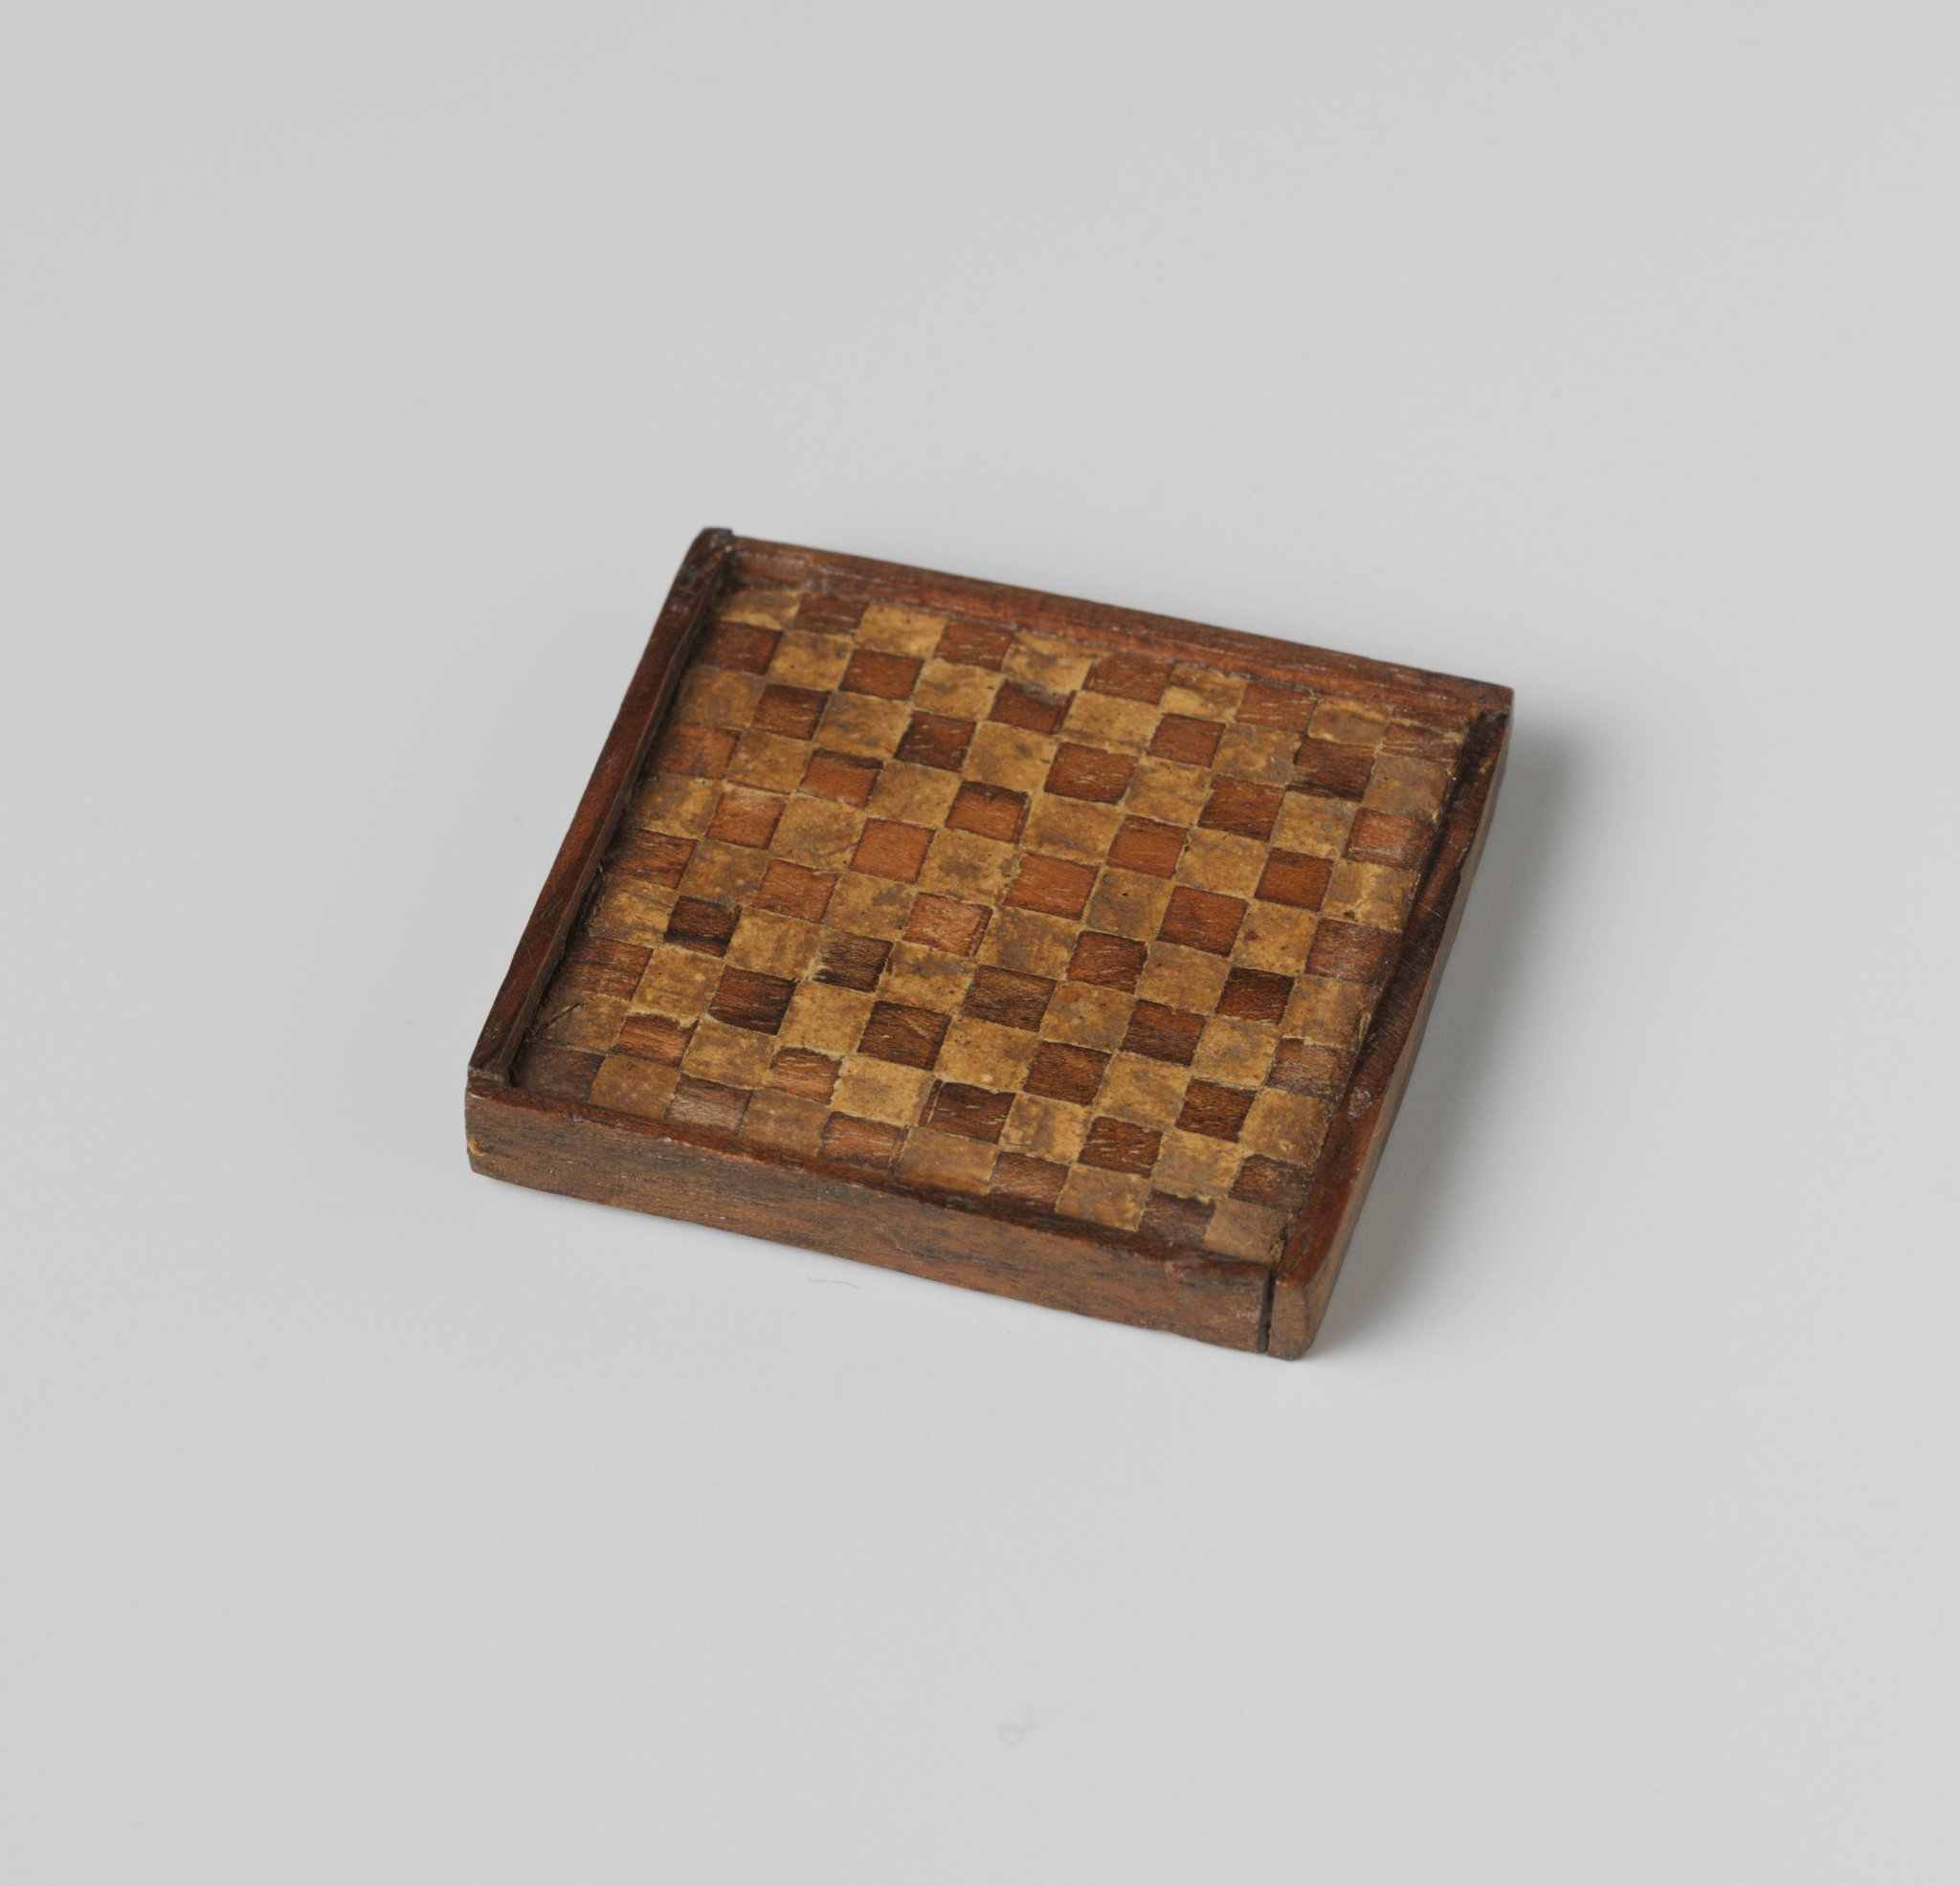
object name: miniature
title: Spelbord, te gebruiken als dambord en molenspelbord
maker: Anonymous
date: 1740-1760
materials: wood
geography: amsterdam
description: Spelbord van notenhout, nagenoeg vierkant, met een opstaande rand. Aan een kant te gebruiken als dambord, met uitgestoken vierkanten, gevuld met lichte vulpasta; aan de andere kant als molenspelbord met ingegutste lijnen, eveneens met lichtere pasta gevuld.